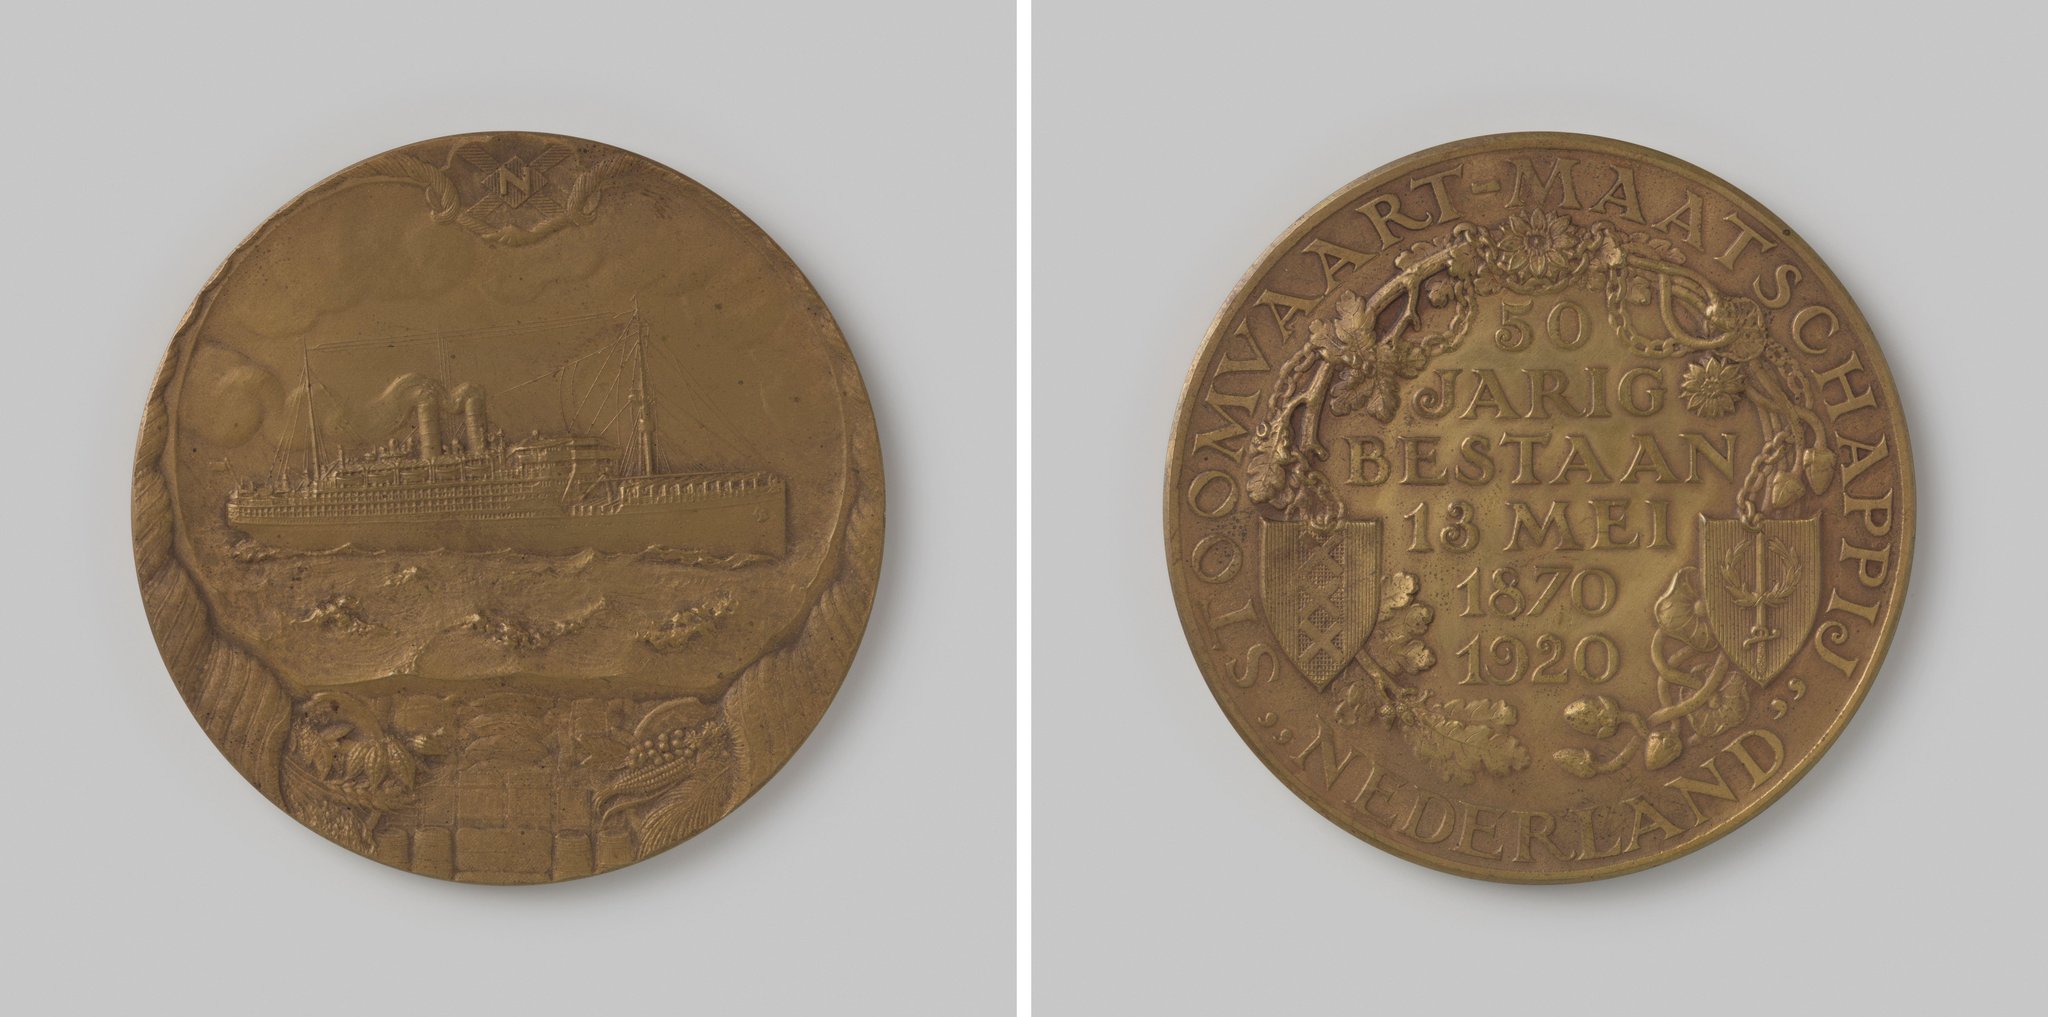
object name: history medal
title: Vijftigjarig bestaan van de Stoomvaart Maatschappij Nederland 1920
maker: johannes cornelis wienecke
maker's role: medailleur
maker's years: 1872-1945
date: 1920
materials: bronze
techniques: striking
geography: utrecht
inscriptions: factory mark: ‘mercuriusstaf’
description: Bronzen penning, op de voorzijde een passagiersschip op zee naar rechts tussen twee hoorns des overvloeds, met boven de maatschappijvlag en onder kratten en zakken koopwaar, op de keerzijde zes regels tekst binnen een eiken- en bloemenkrans waarop links en rechts de door een ketting verbonden wapenschilden van Amsterdam en Batavia, met omschrift.